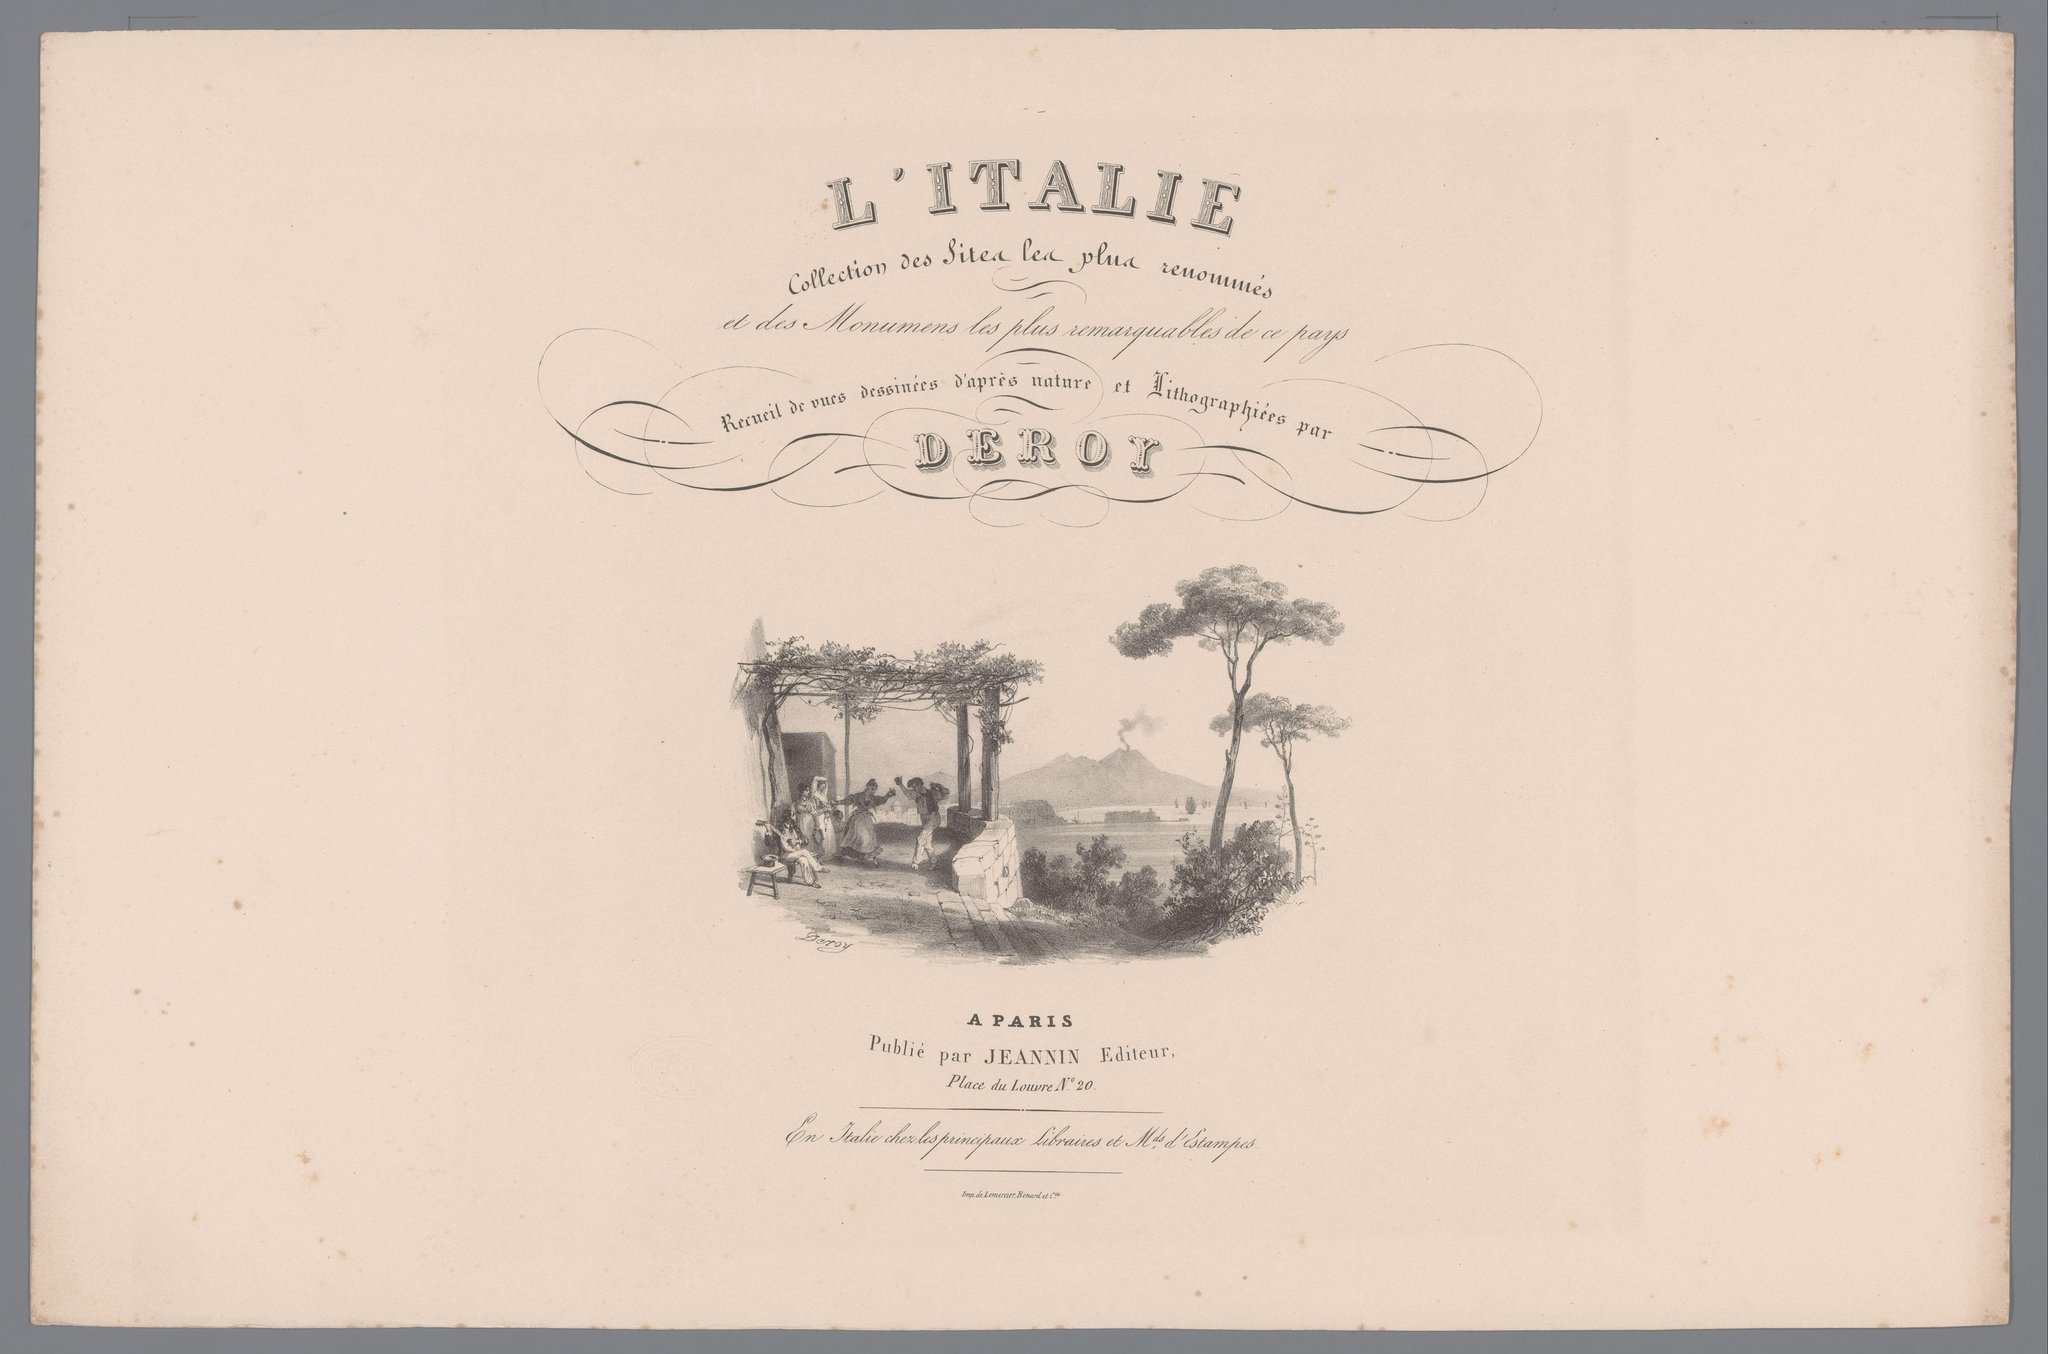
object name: titelprent, frontispice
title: Gezichten in Italië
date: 1838-1841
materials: paper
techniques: lithograph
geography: paris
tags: folk dancing (men and women together), mountains (+ landscape with figures, staffage)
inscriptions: collector's mark: Lugt 2228a, check stamp: Lugt 1397c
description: Titelprent van de serie 'Gezichten in Italië', een reeks van 120 prenten. Deze is onderverdeeld in kleinere reeksen van zes tot tien prenten, waarvan het Rijksmuseum er vijf bezit.